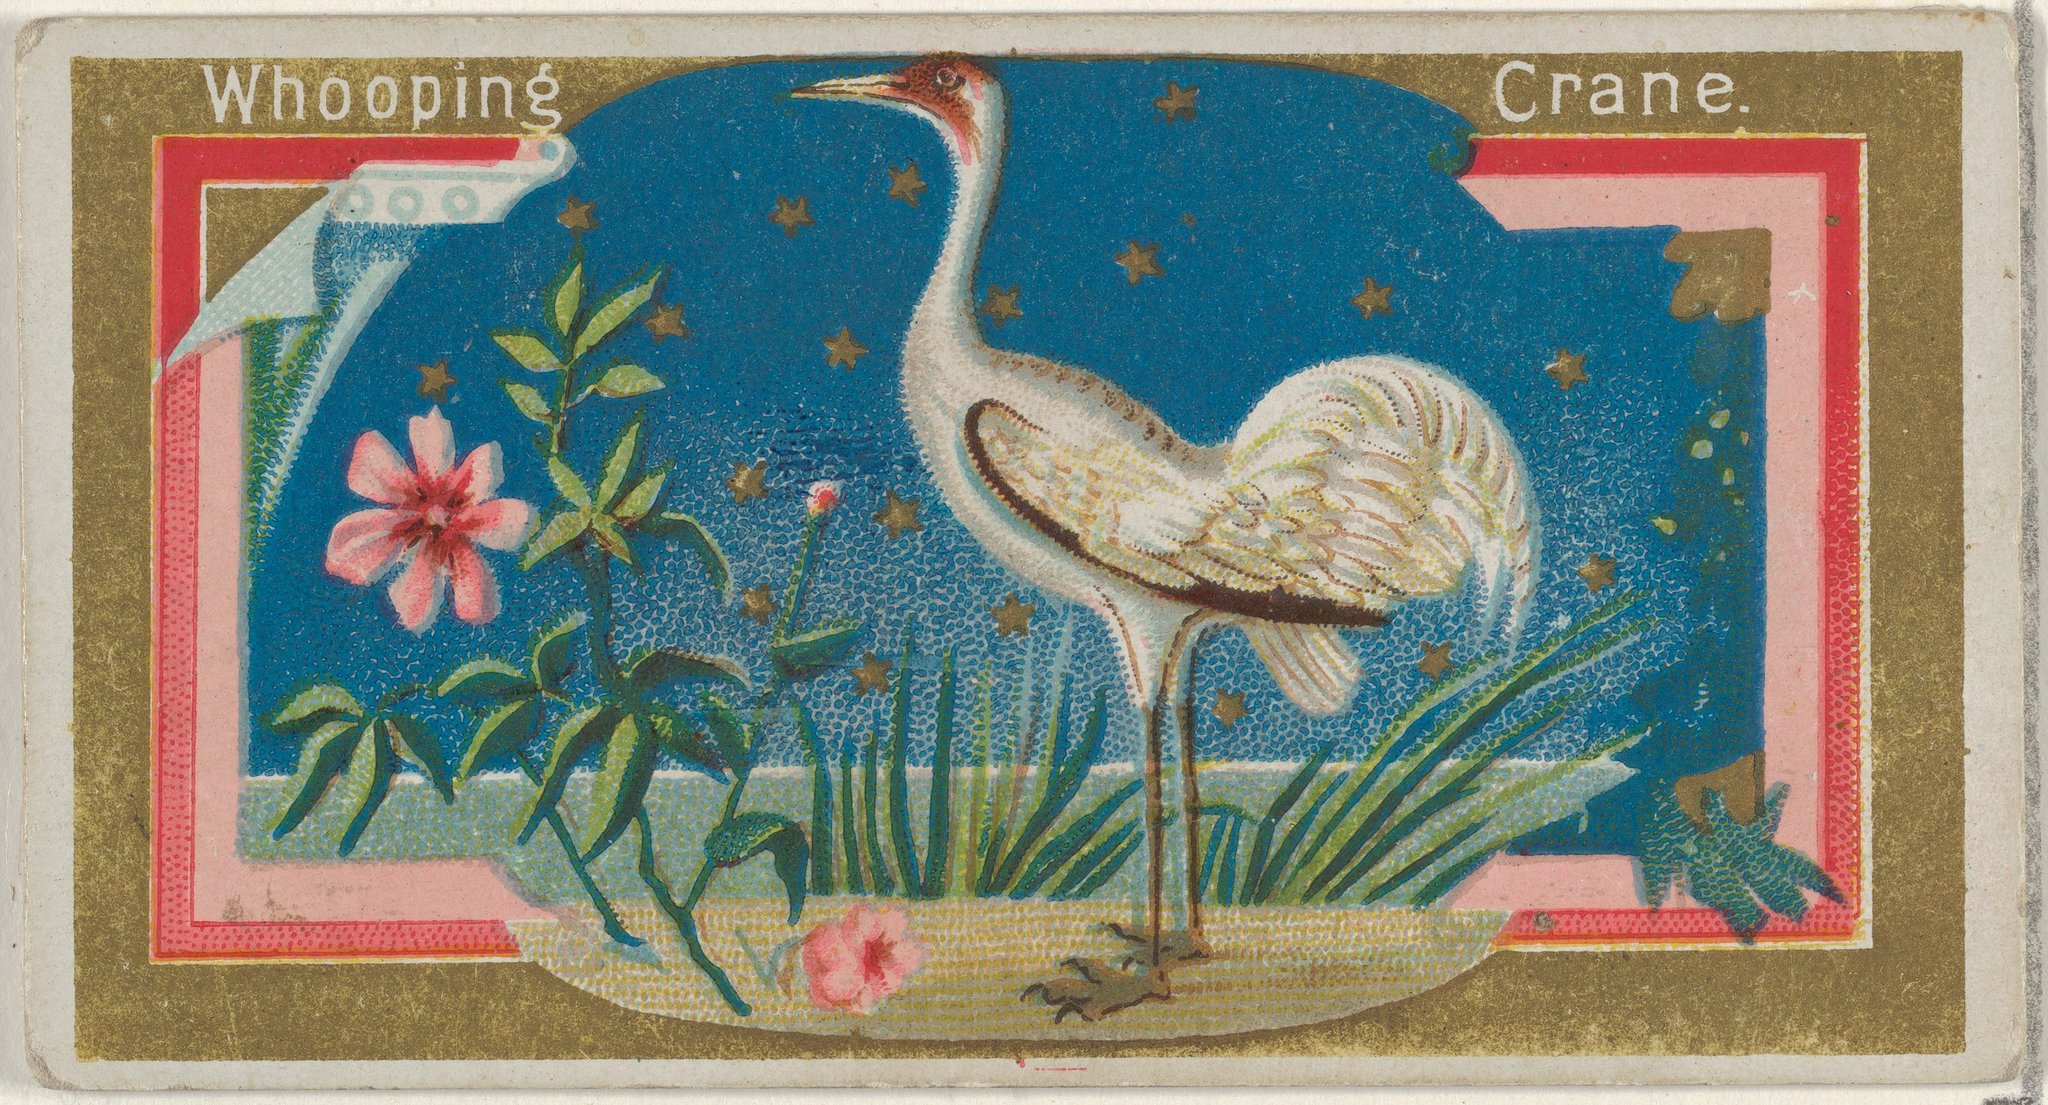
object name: print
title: Whopping Crane, from the Game Birds series (N13) for Allen & Ginter Cigarettes Brands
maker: allen & ginter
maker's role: publisher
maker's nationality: american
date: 1889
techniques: color lithograph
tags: cranes